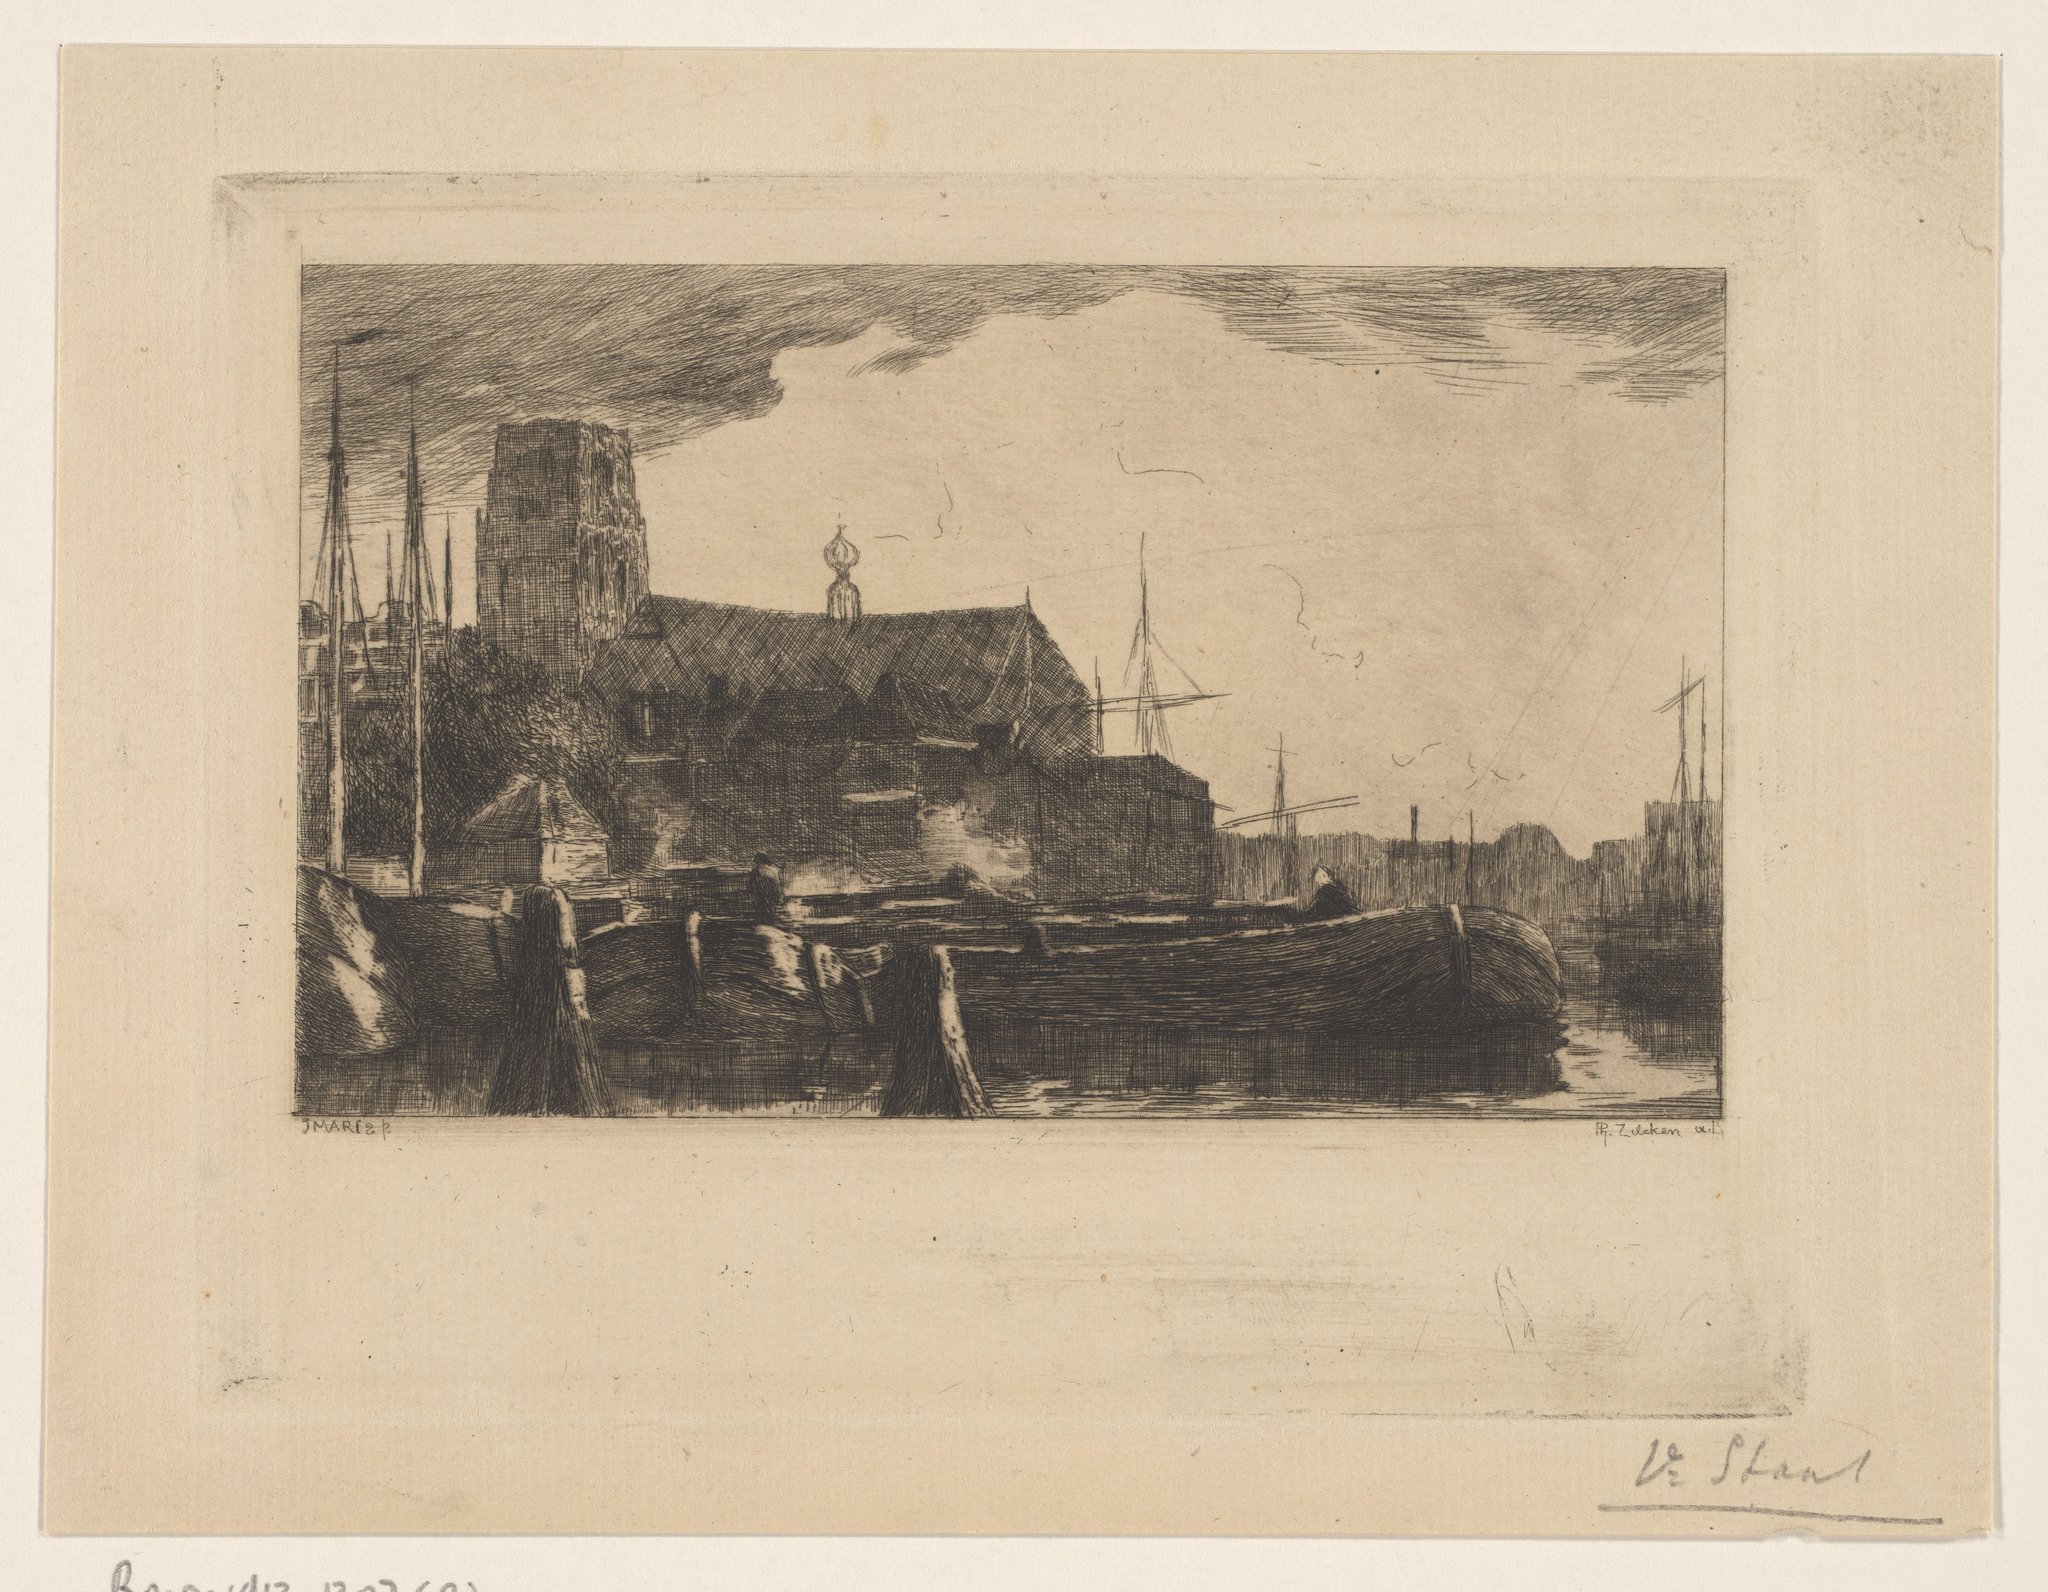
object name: print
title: Souvenir de Dordrecht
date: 1888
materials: paper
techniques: drypoint, etching, intaglio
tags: church (exterior), prospect of city, town panorama, silhouette of city, dordrecht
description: Prent is ook gebruikt in: Memorial catalogue of the French and Dutch. Edinburgh: David Douglas, 1888.